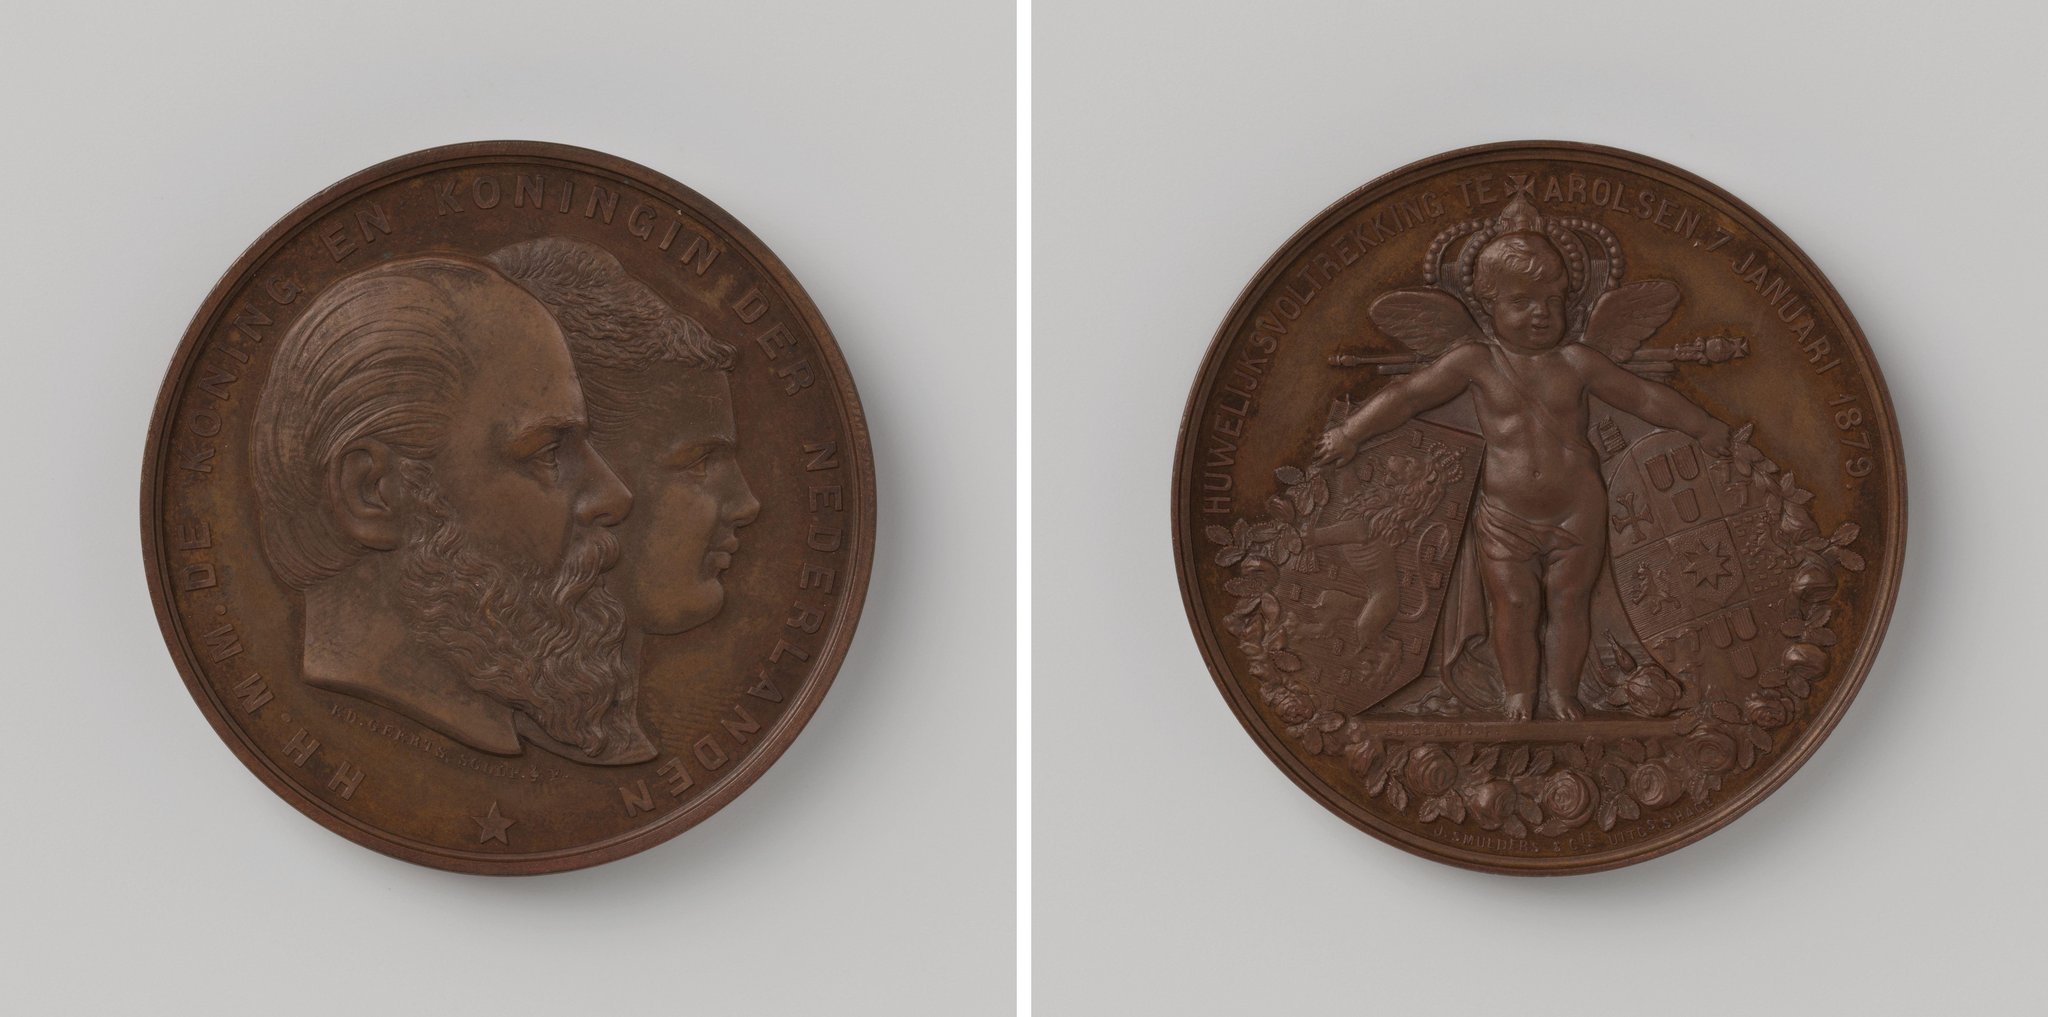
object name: history medal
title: Huwelijk van Willem III, koning der Nederlanden en Emma, prinses van Waldeck-Pyrmont te Arolsen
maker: edouard louis geerts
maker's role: medailleur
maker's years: 1846-1889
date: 1879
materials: bronze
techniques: striking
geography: brussels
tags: the hague, emma (queen consort of the netherlands), brussels, willem iii (koning der nederlanden)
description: Bronzen penning. Voorzijde: borststuk man en vrouw binnen omschrift. Keerzijde: staande voor altaar, waarop kroon en scepter liggen, houdt engel bloemenguirlande om twee wapenschilden binnen omschrift